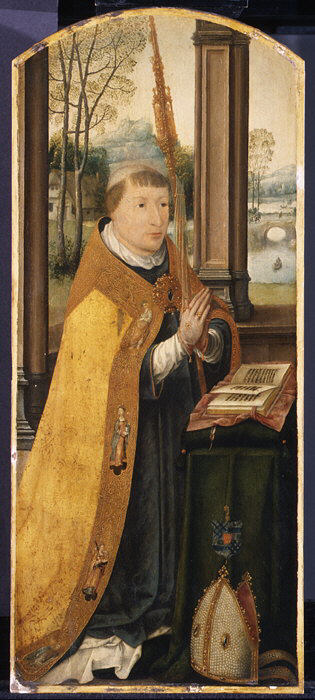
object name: painting, wing of a triptych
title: Charles de Saint-Radegonde, called Charles Coguin, Abbot of Anchin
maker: jean bellegambe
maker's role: artist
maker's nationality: french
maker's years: 1470-1536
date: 1511-1520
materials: oil, wood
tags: men,portraits